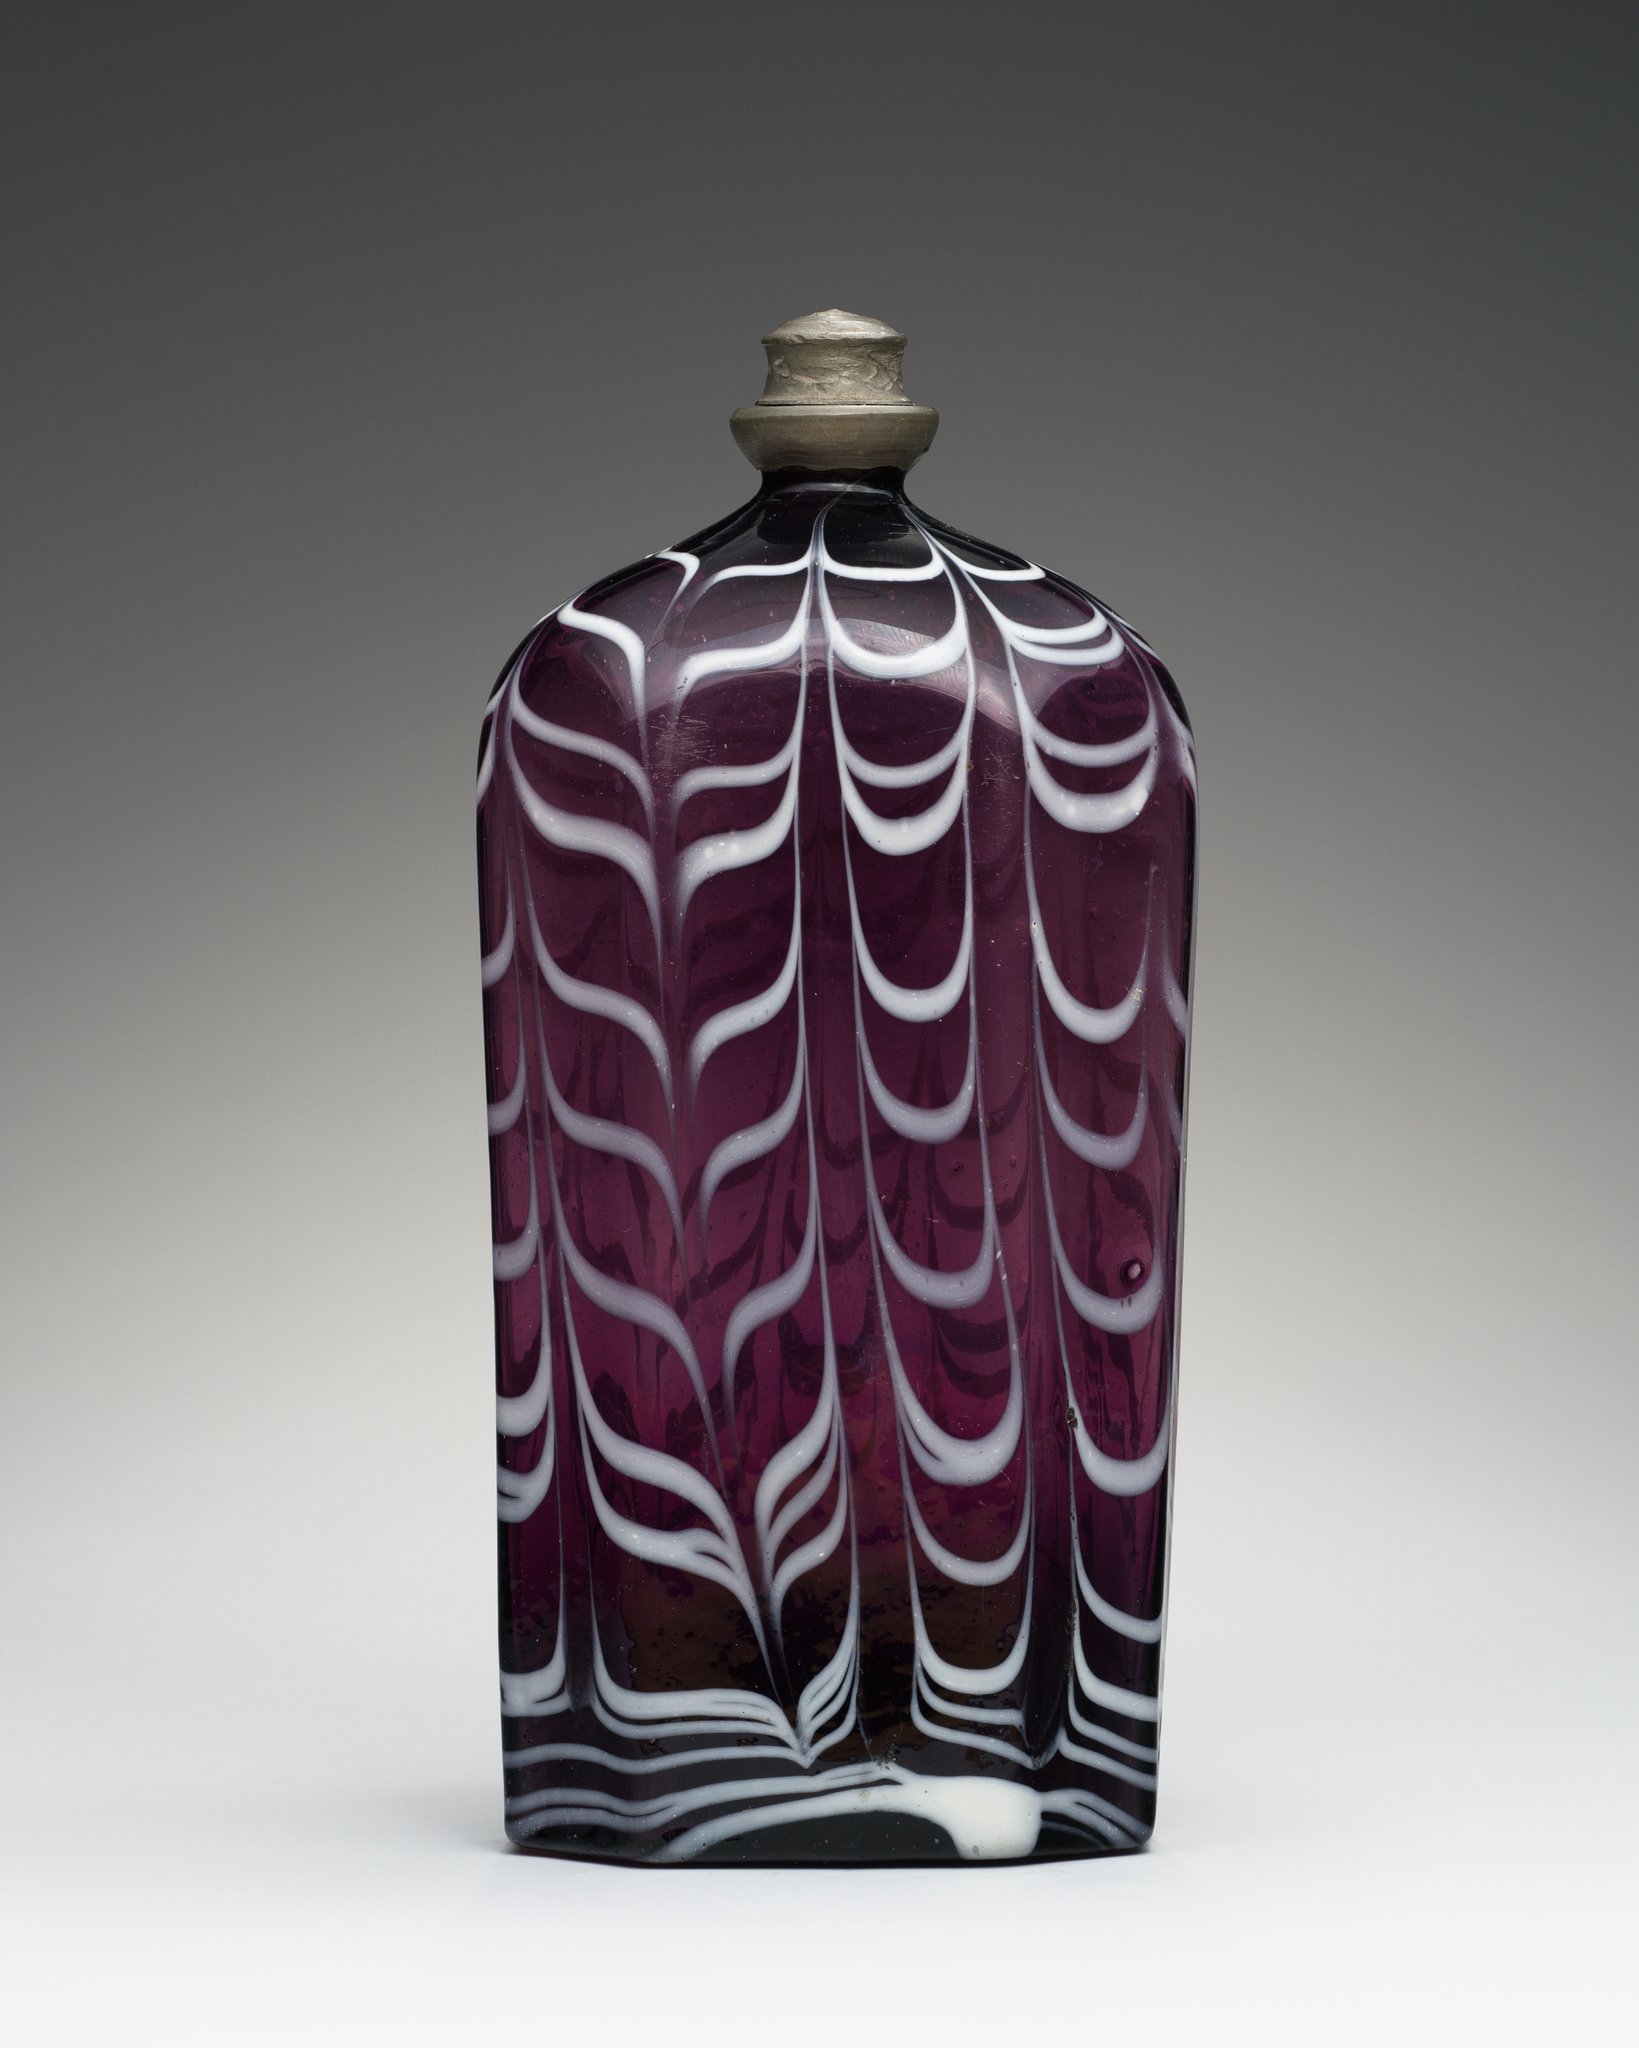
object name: bottle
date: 1701-1800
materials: glass, pewter